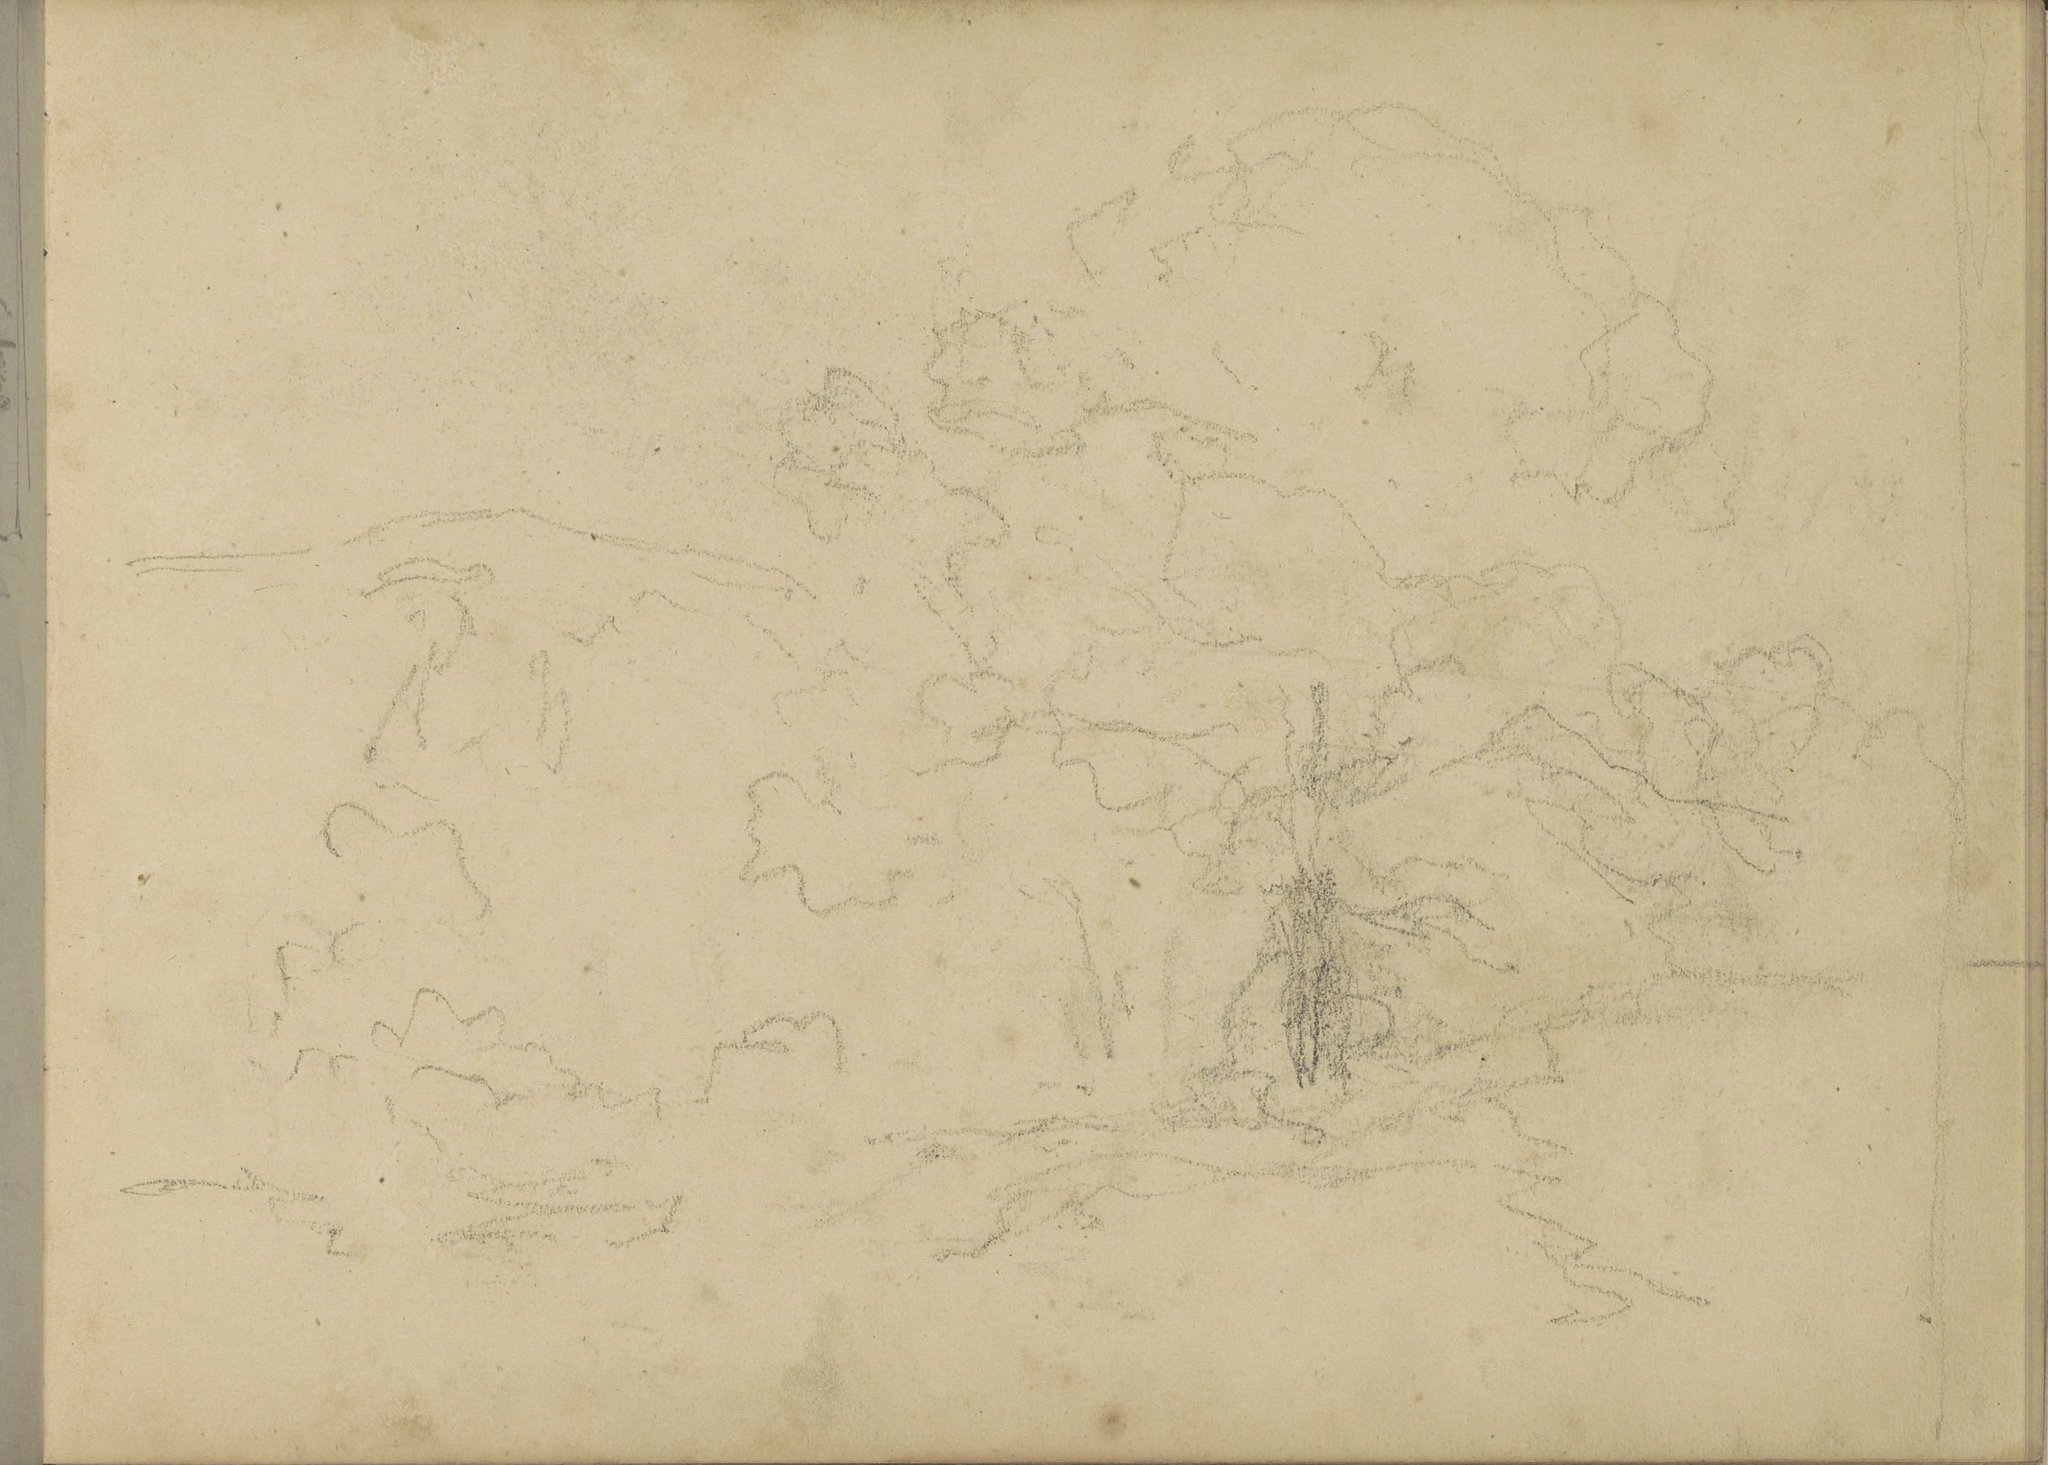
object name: sketchbook leaf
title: Landschap met bomen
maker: willem roelofs (i)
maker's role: draughtsman, painter, print maker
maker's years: 1822-1897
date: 1846-1851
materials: paper, pencil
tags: landscapes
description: Blad 13 recto uit een schetsboek met 25 bladen.